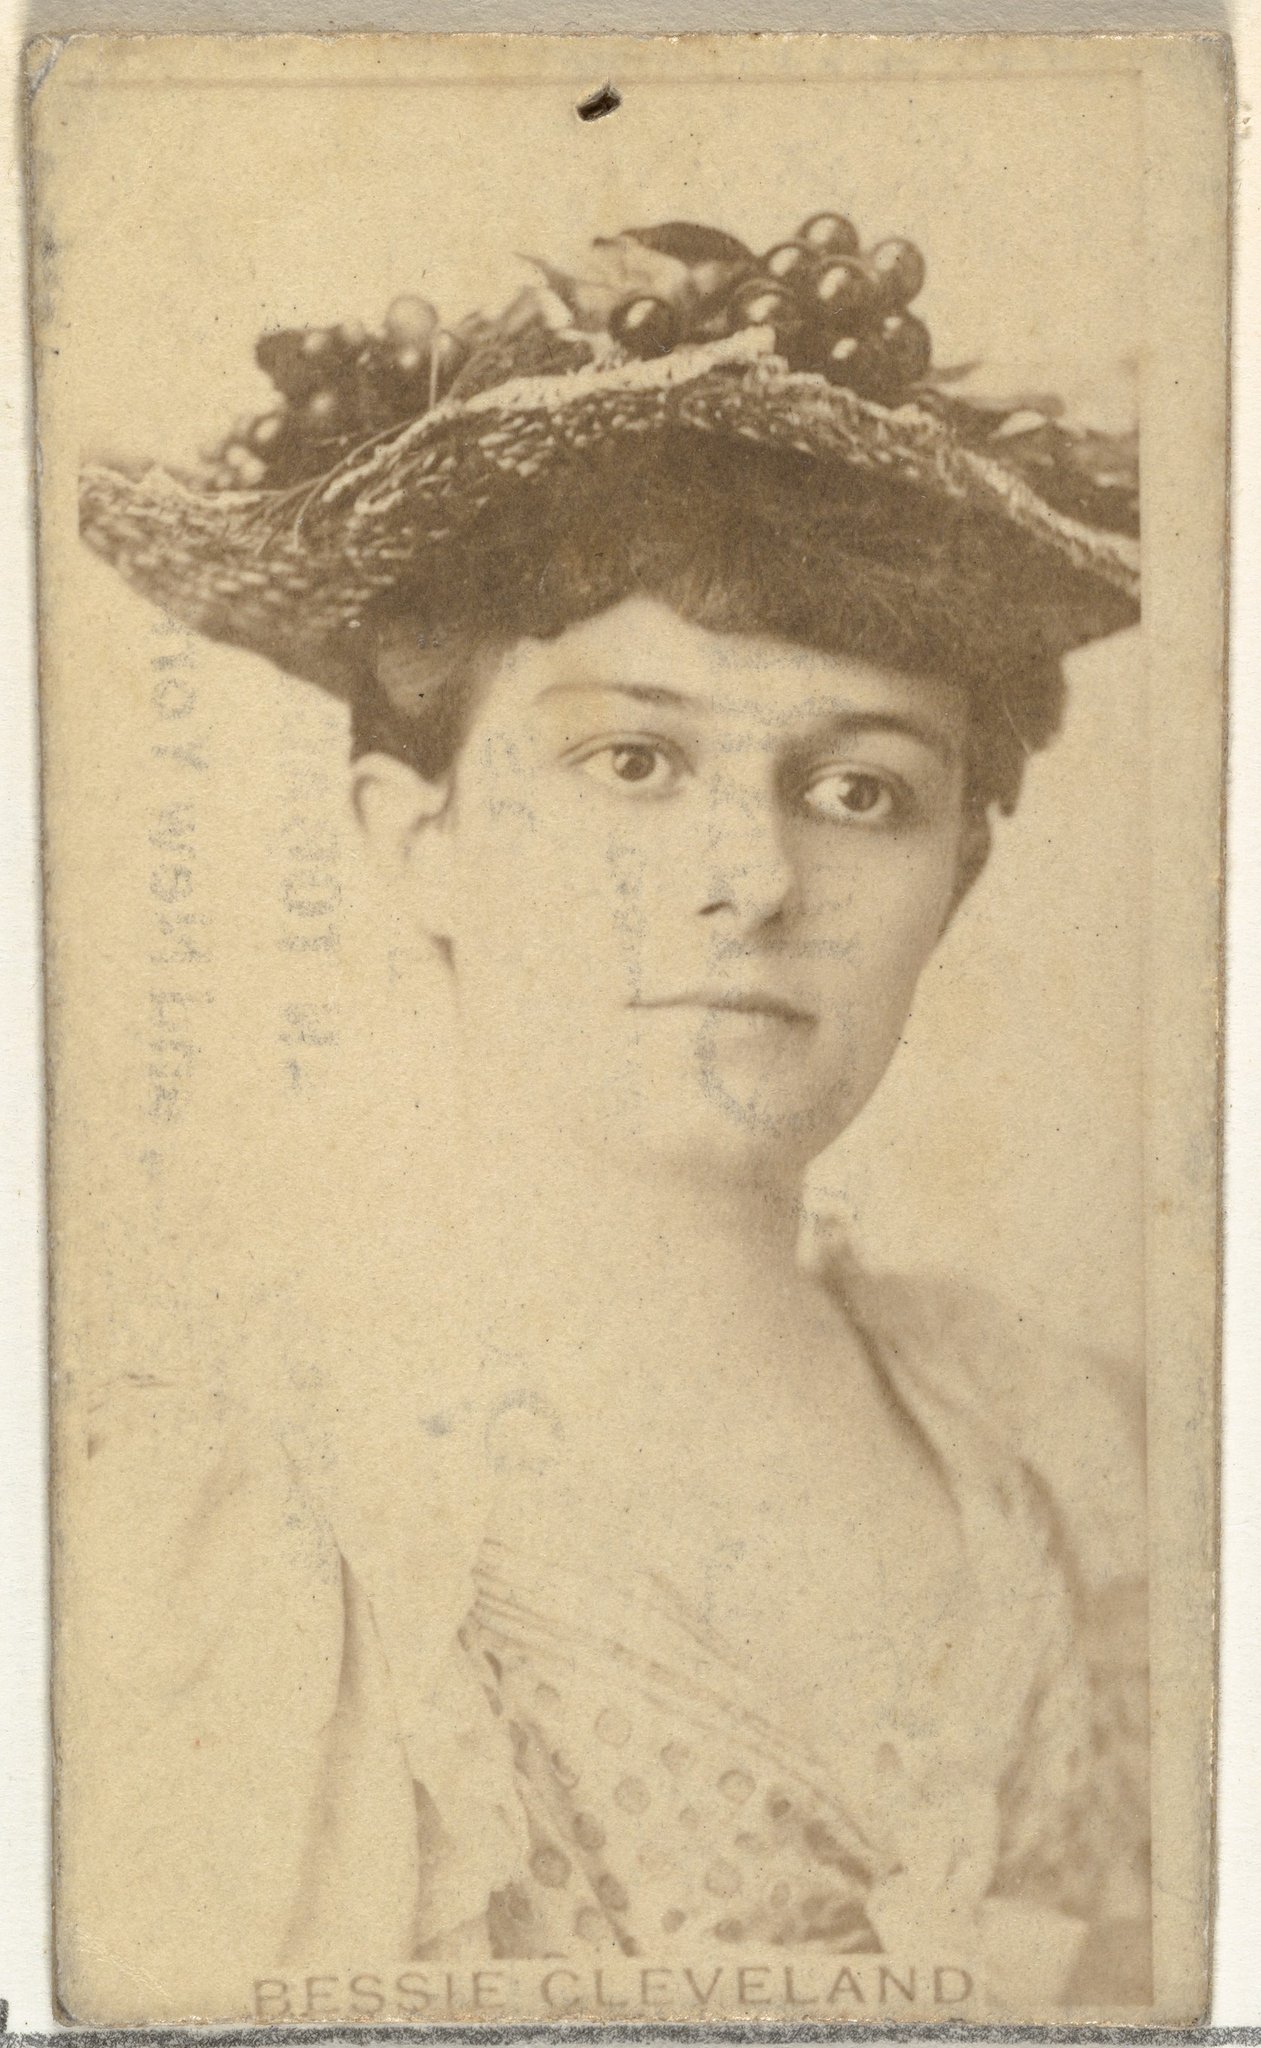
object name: photograph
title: Bessie Cleveland, from the Actors and Actresses series (N145-8) issued by Duke Sons & Co. to promote Duke Cigarettes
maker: w. duke, sons & co.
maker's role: publisher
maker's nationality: american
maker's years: 1870-1920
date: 1891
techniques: albumen silver print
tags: portraits,women,actresses